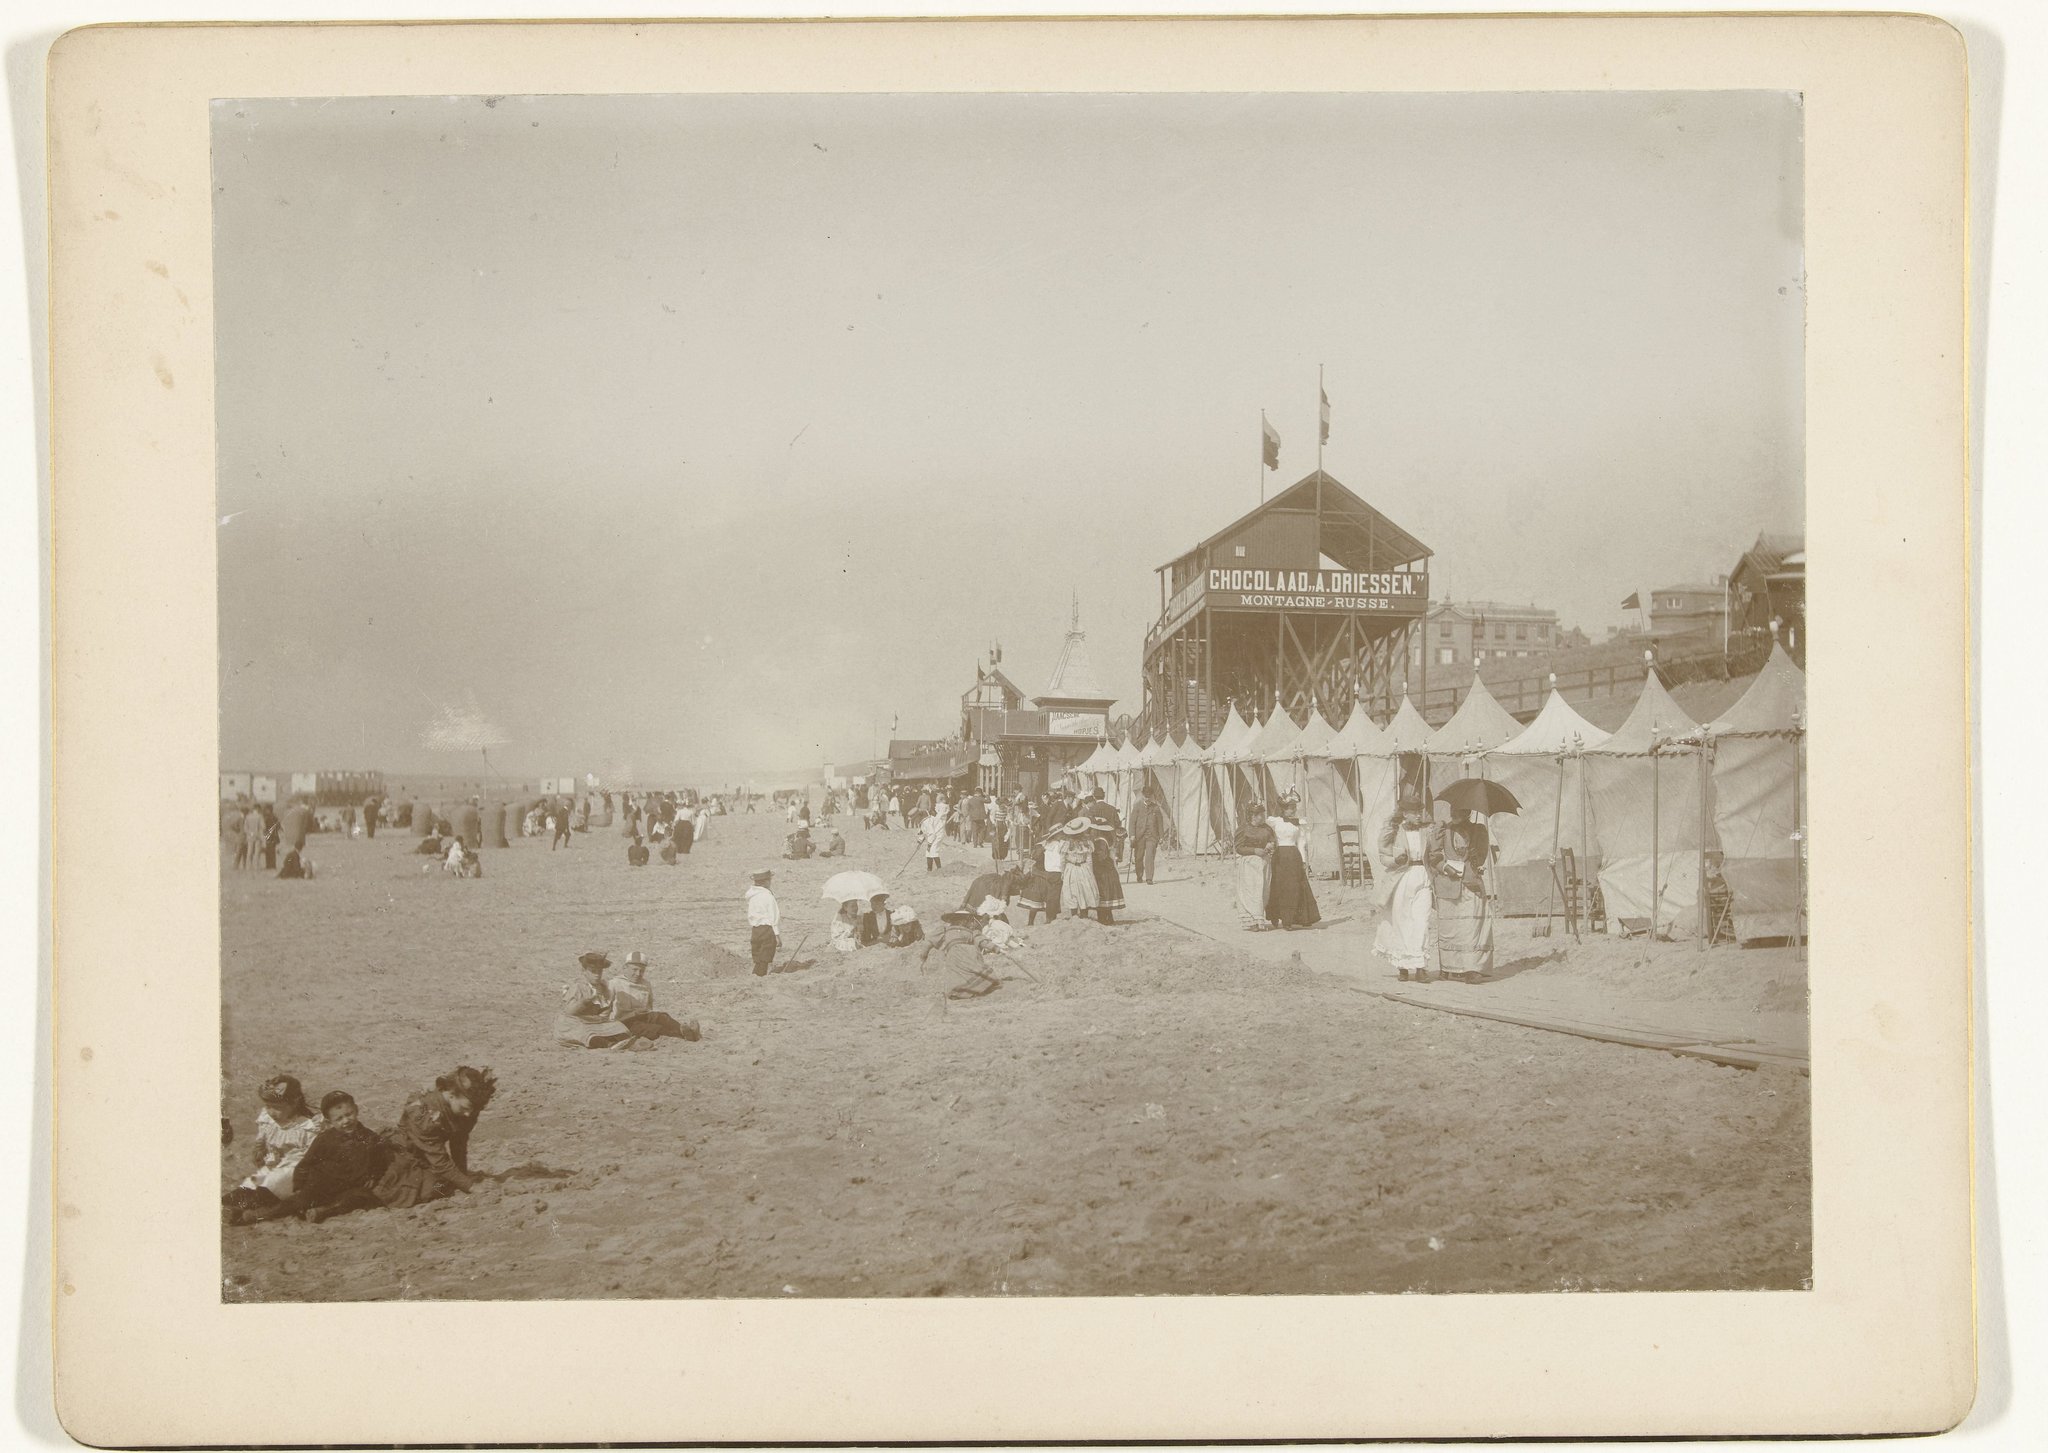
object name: photograph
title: Gezicht op het strand bij Scheveningen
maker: henry pauw van wieldrecht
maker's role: fotograaf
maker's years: 1863-1912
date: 1894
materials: cardboard, photographic support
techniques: gelatin silver print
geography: netherlands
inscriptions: annotation: ‘No. 825. 1894.’